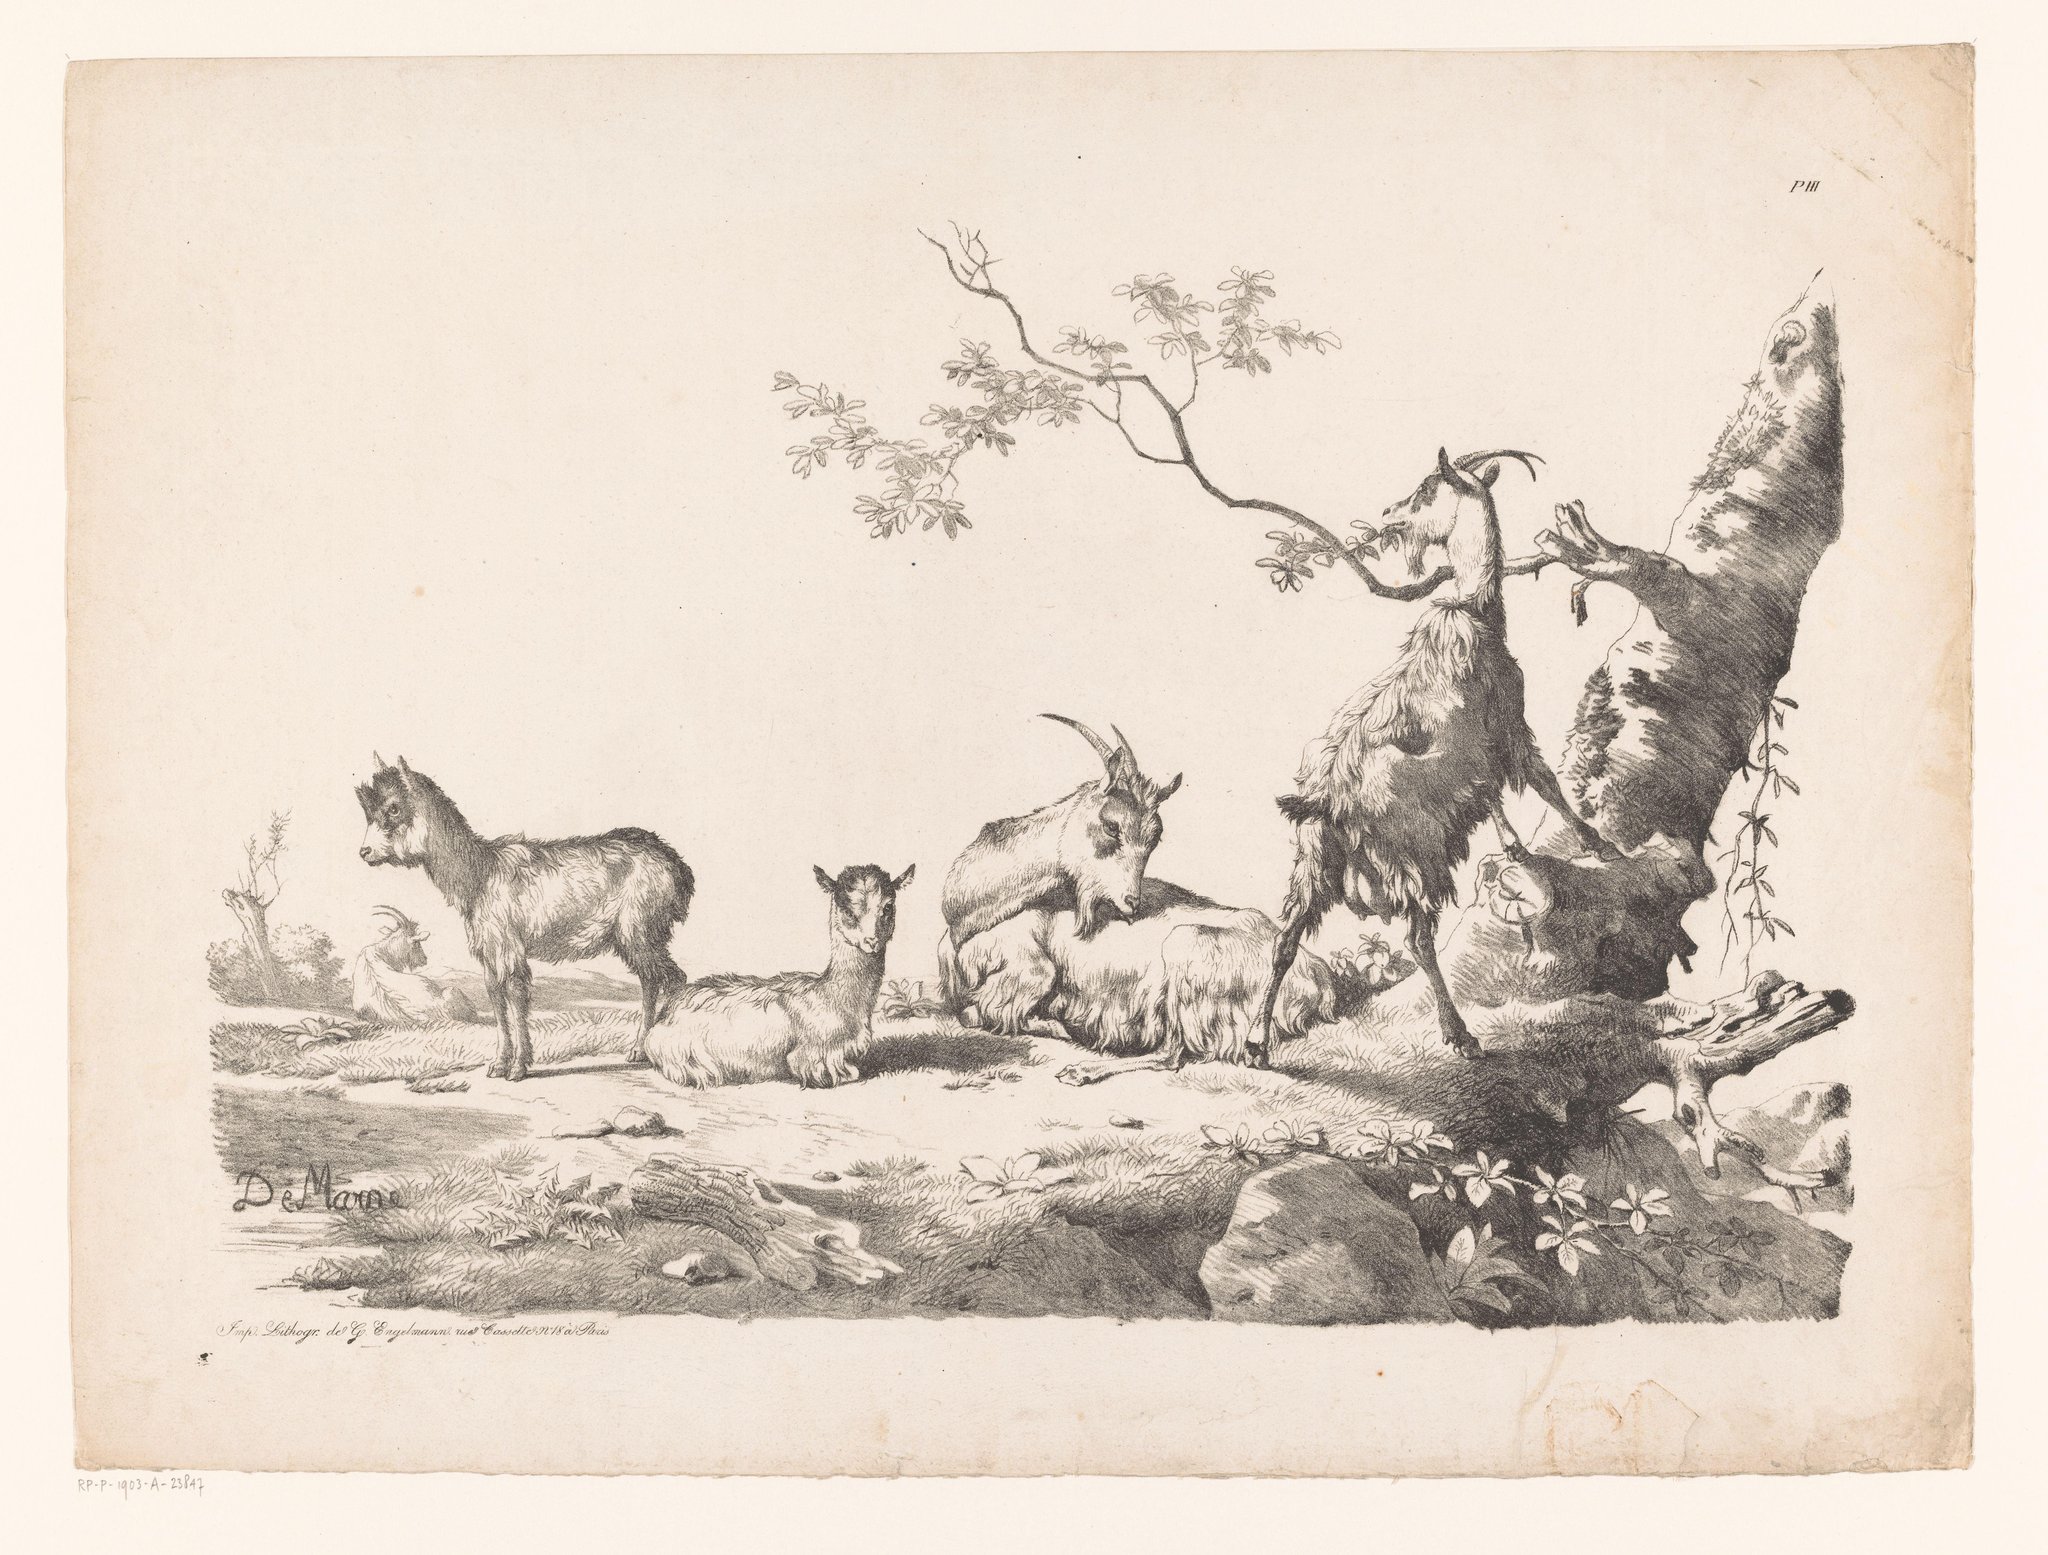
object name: print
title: Geiten met jongen in een landschap bij een boom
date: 1816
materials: paper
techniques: lithograph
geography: paris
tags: landscapes, goat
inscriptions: collector's mark: Lugt 2228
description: Prent uit de serie: Demarne, Jean Louis. Cours complet d'études du dessin: animaux I. Études de chevres. Parijs: Engelmann, 1816.